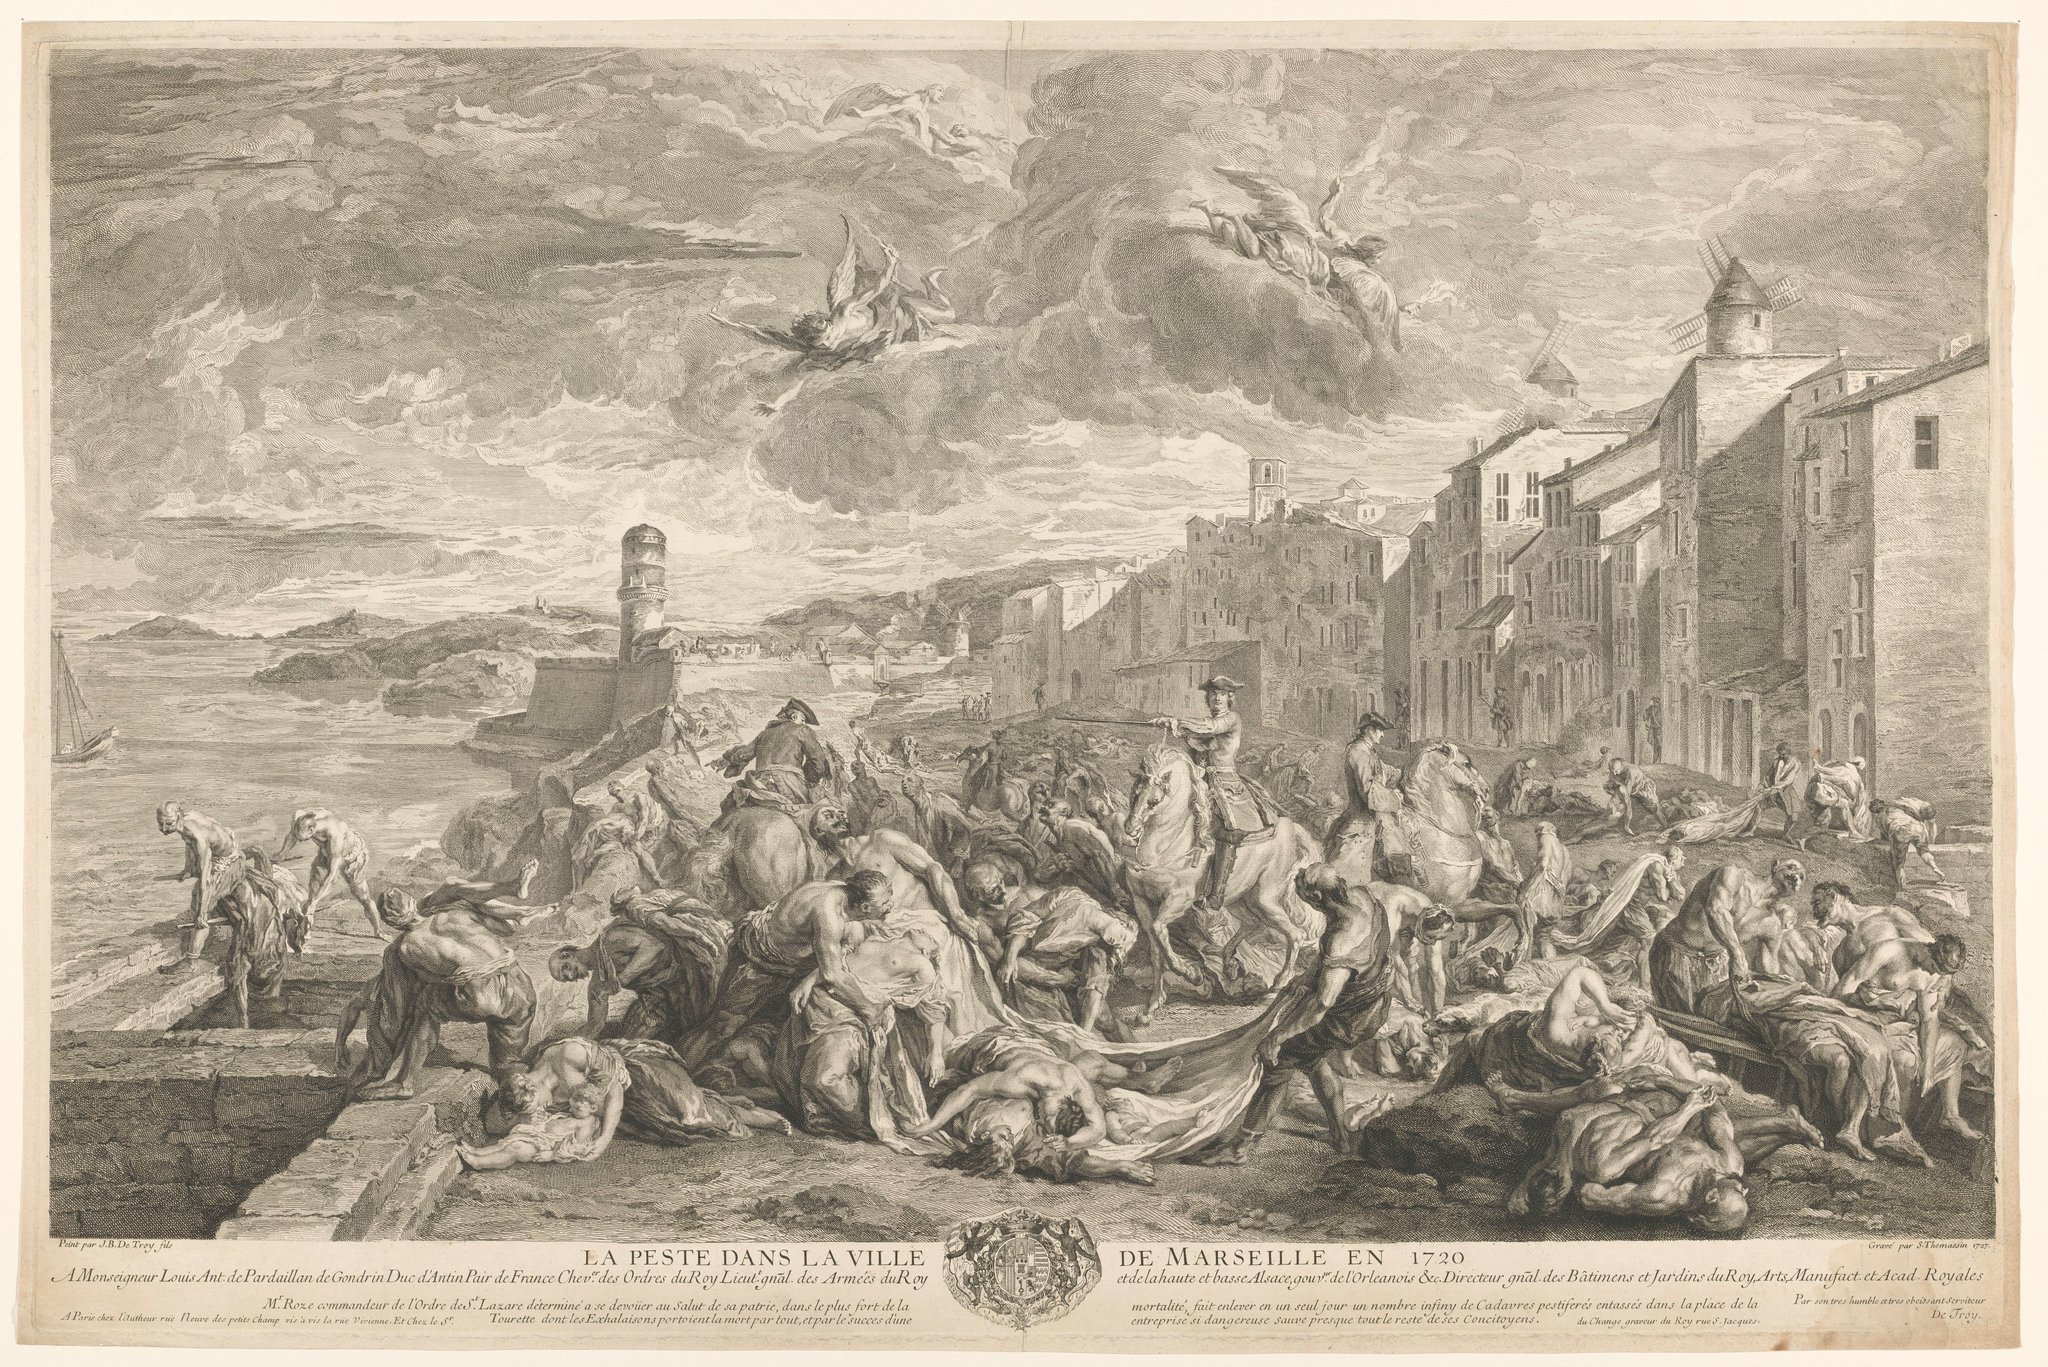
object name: print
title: La Peste dans la ville de Marseille en 1720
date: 1727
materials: paper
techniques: engraving, etching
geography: france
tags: harbour, slavery; serfs and enslaved persons, quay, plague, marseille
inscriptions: collector's mark: Lugt 240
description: In de wijk La Tourette worden de lichamen van de pestslachtoffers onder leiding van Nicolas Roze (Chevalier Roze) geruimd door galeiroeiers en soldaten. Op de galeien werd voornamelijk gebruik gemaakt van onvrije arbeidskrachten. Veel van de roeiers waren islamitische galeislaven, die ook hier als dusdanig te herkennen zijn door hun enkelboeien en het typerende kapsel (hoofd op een pluk na kaalgeschoren) dat zij verplicht waren te hebben. Hiermee waren ze te onderscheiden van bijvoorbeeld politieke gevangenen die tot de galeien veroordeeld waren. De galeiroeiers die hielpen bij het ruimen van de pestslachtoffers in Marseille was in ruil daarvoor vrijheid beloofd, maar het merendeel van hen bezweek zelf aan de ziekte.